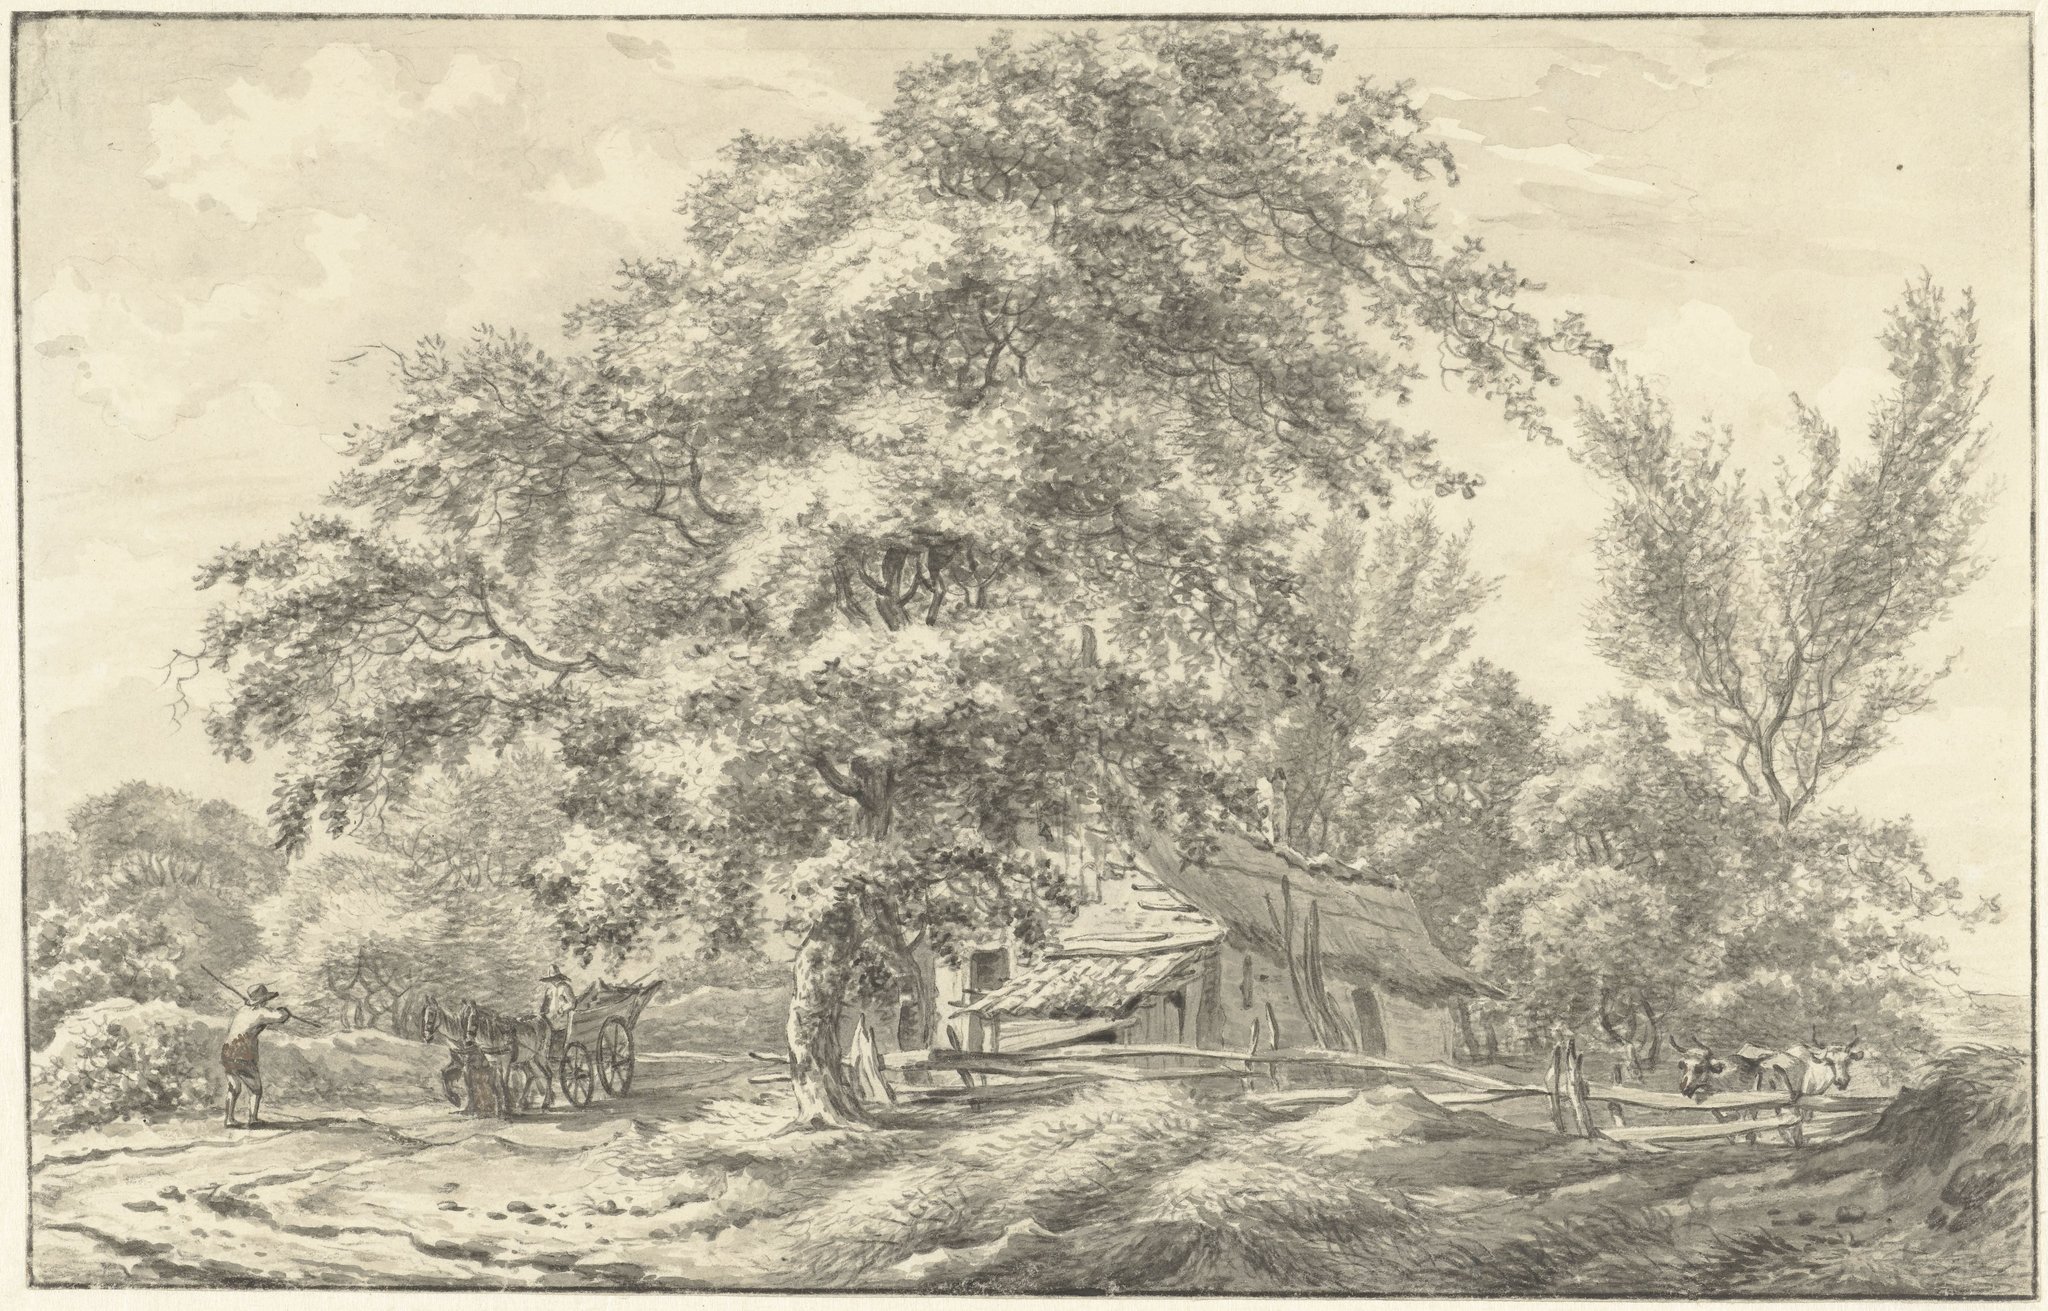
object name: drawing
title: Boerderij onder bomen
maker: hermanus fock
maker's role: conservator, draughtsman, painter, print maker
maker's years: 1766-1822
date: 1776-1822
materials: chalk, paper, pencil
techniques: brush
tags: farm or solitary house in landscape